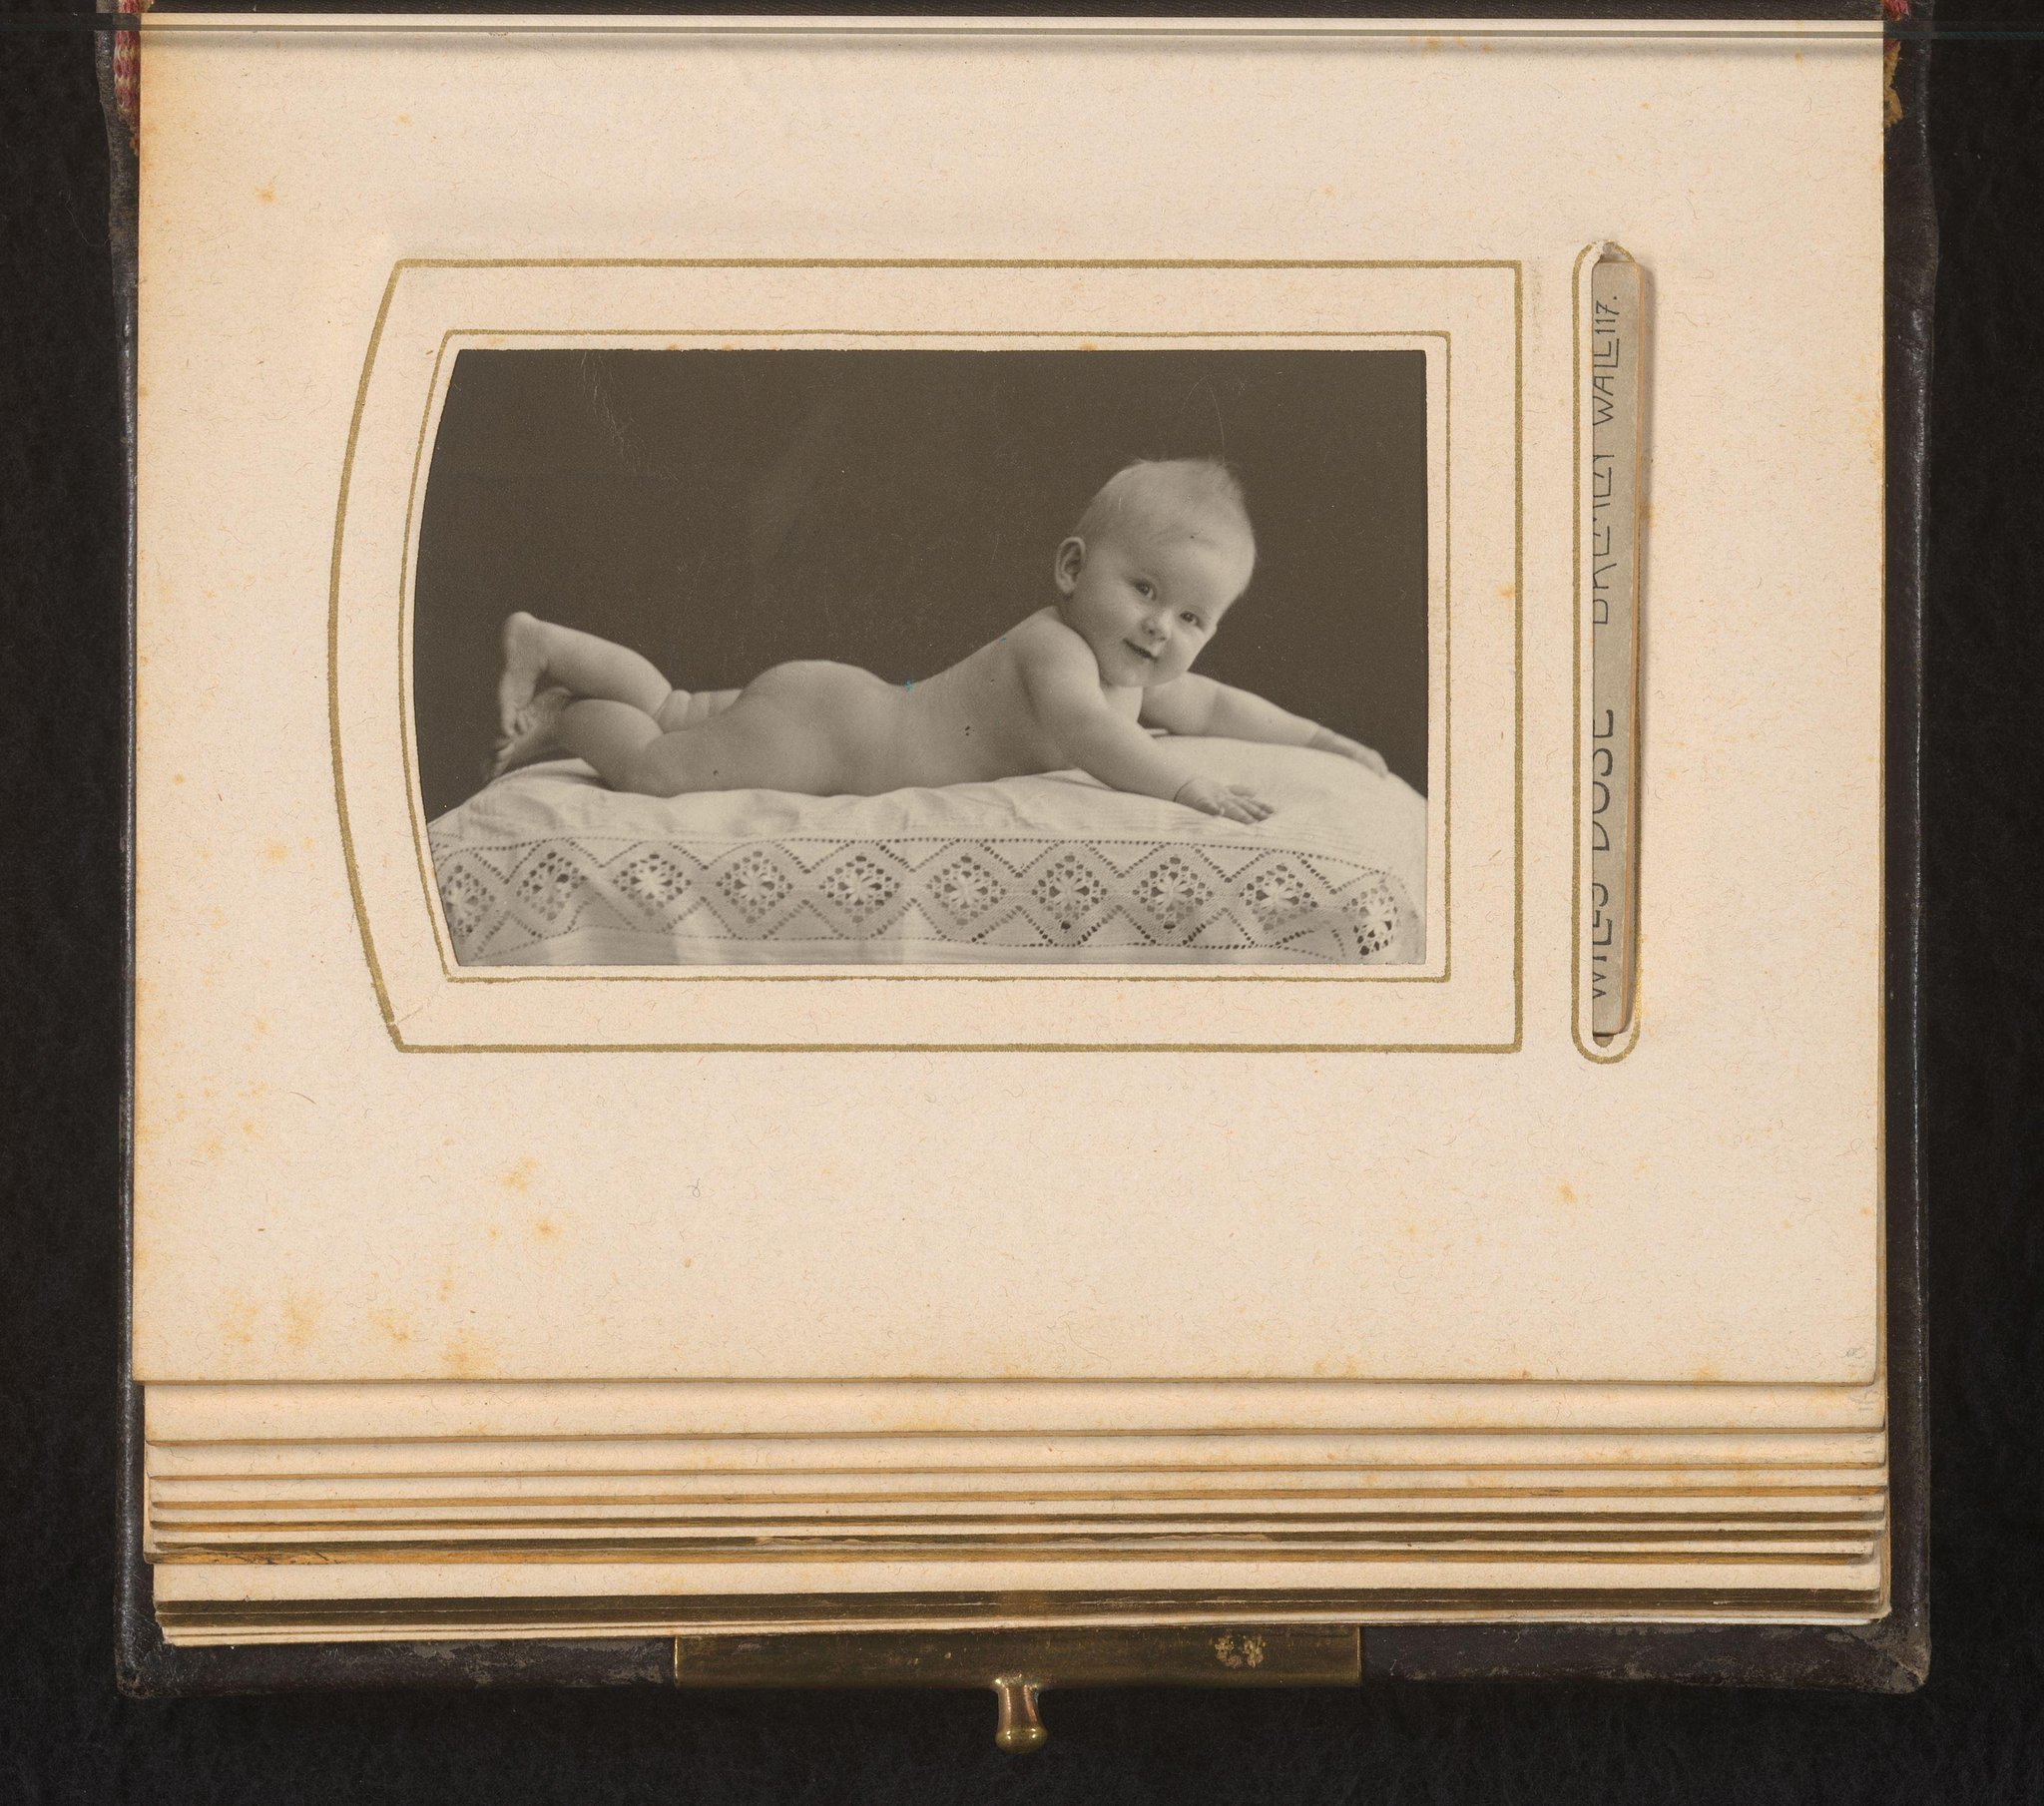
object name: photograph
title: Portret van een baby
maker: willy dose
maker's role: fotograaf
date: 1900-1910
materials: cardboard, photographic support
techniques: collodion silver print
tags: historical persons, infant, baby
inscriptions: inscription: ‘(...)/ Willy Dose/Atelier für mo/ derne Bildnisse/ Bremen/ Wall 117/ (...)’